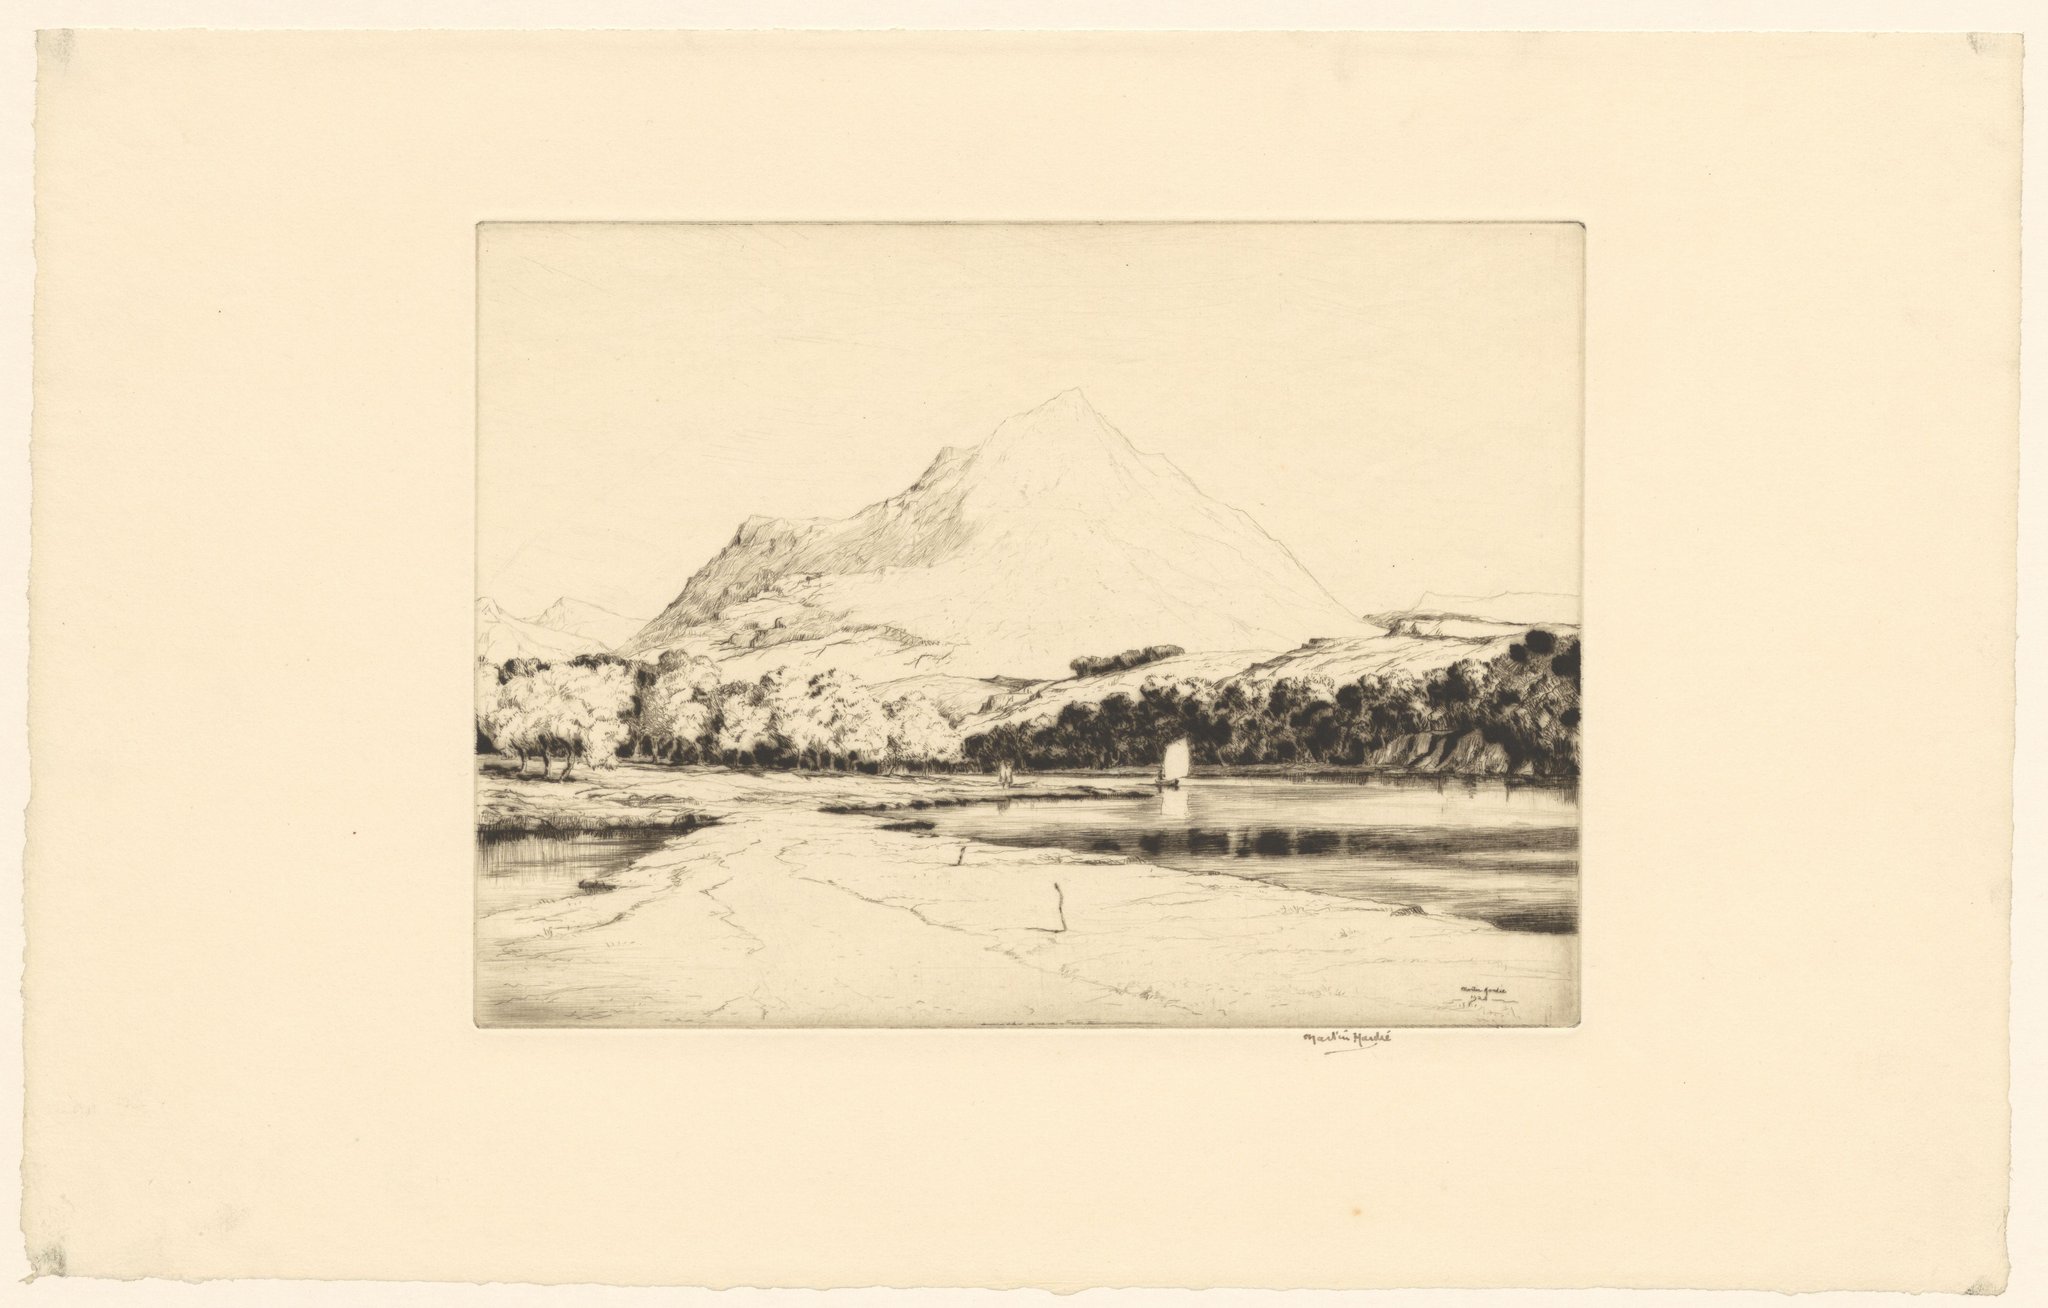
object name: print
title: Berglandschap met meer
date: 1928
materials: paper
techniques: drypoint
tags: sailing-ship, sailing-boat, mountains (+ landscape with figures, staffage), lake (+ landscape with figures, staffage)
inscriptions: annotation: ‘Martin Hardie’, collector's mark: Lugt 2760, collector's mark: Lugt 2228